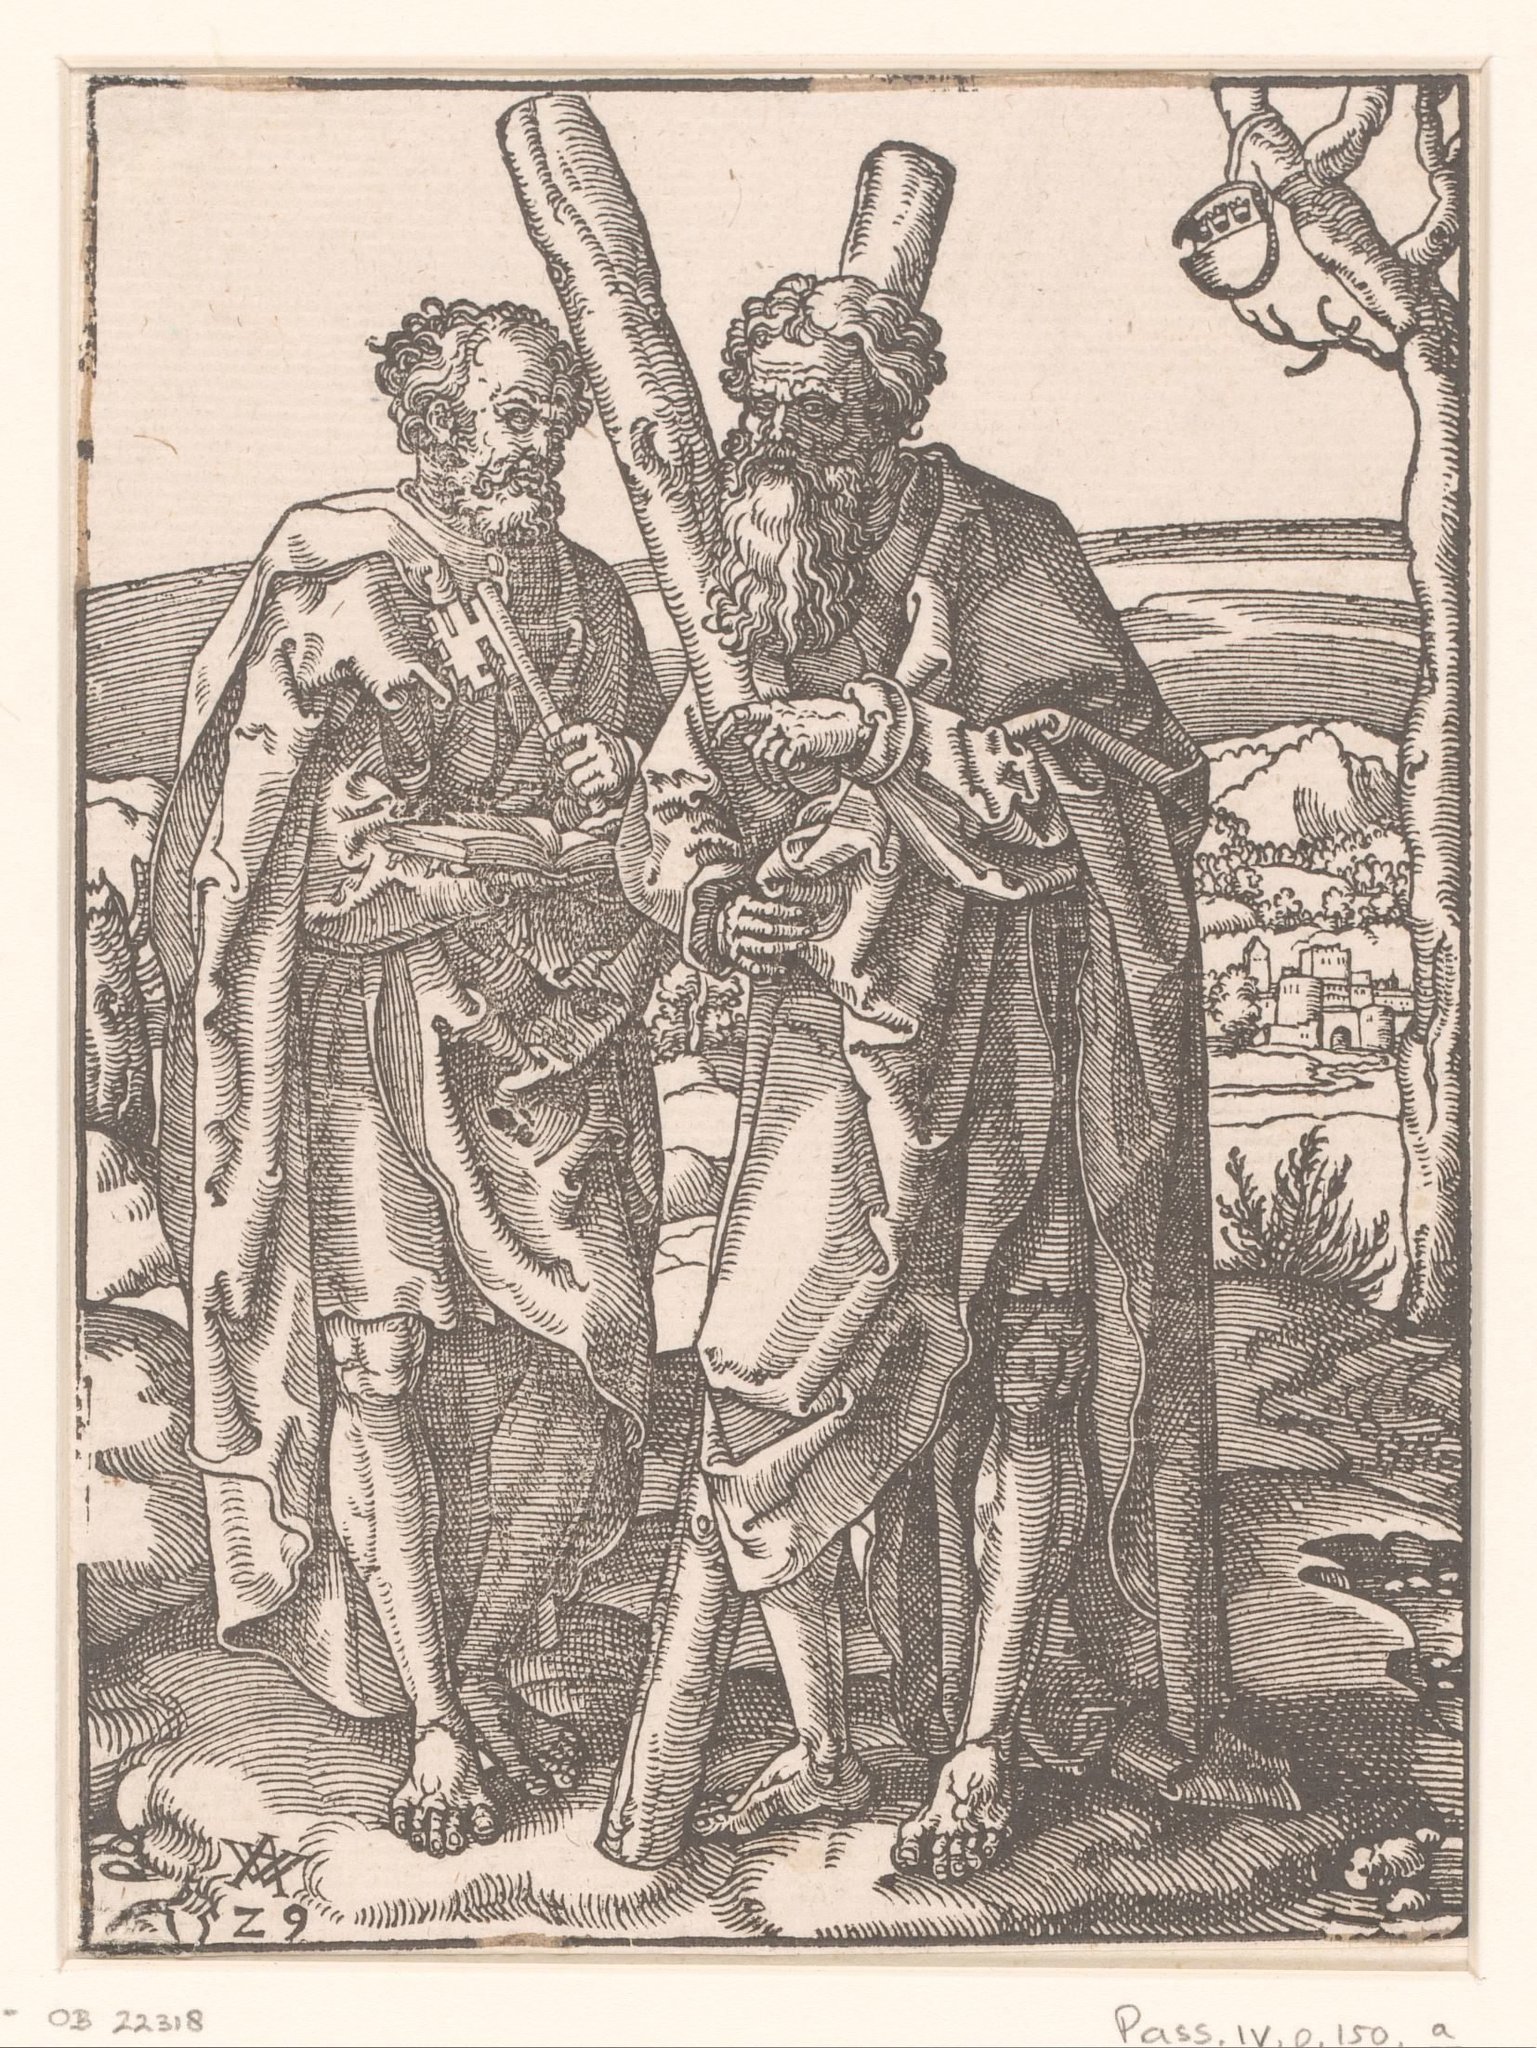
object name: print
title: Twaalf apostelen in paren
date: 1529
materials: paper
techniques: woodcut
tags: the apostle andrew; possible attributes: book, x-shaped cross, fish, fishing-net, rope, scroll, the apostle peter, first bishop of rome; possible attributes: book, cock, (upturned) cross, (triple) crozier, fish, key, scroll, ship, tiara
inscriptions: collector's mark: Lugt 240